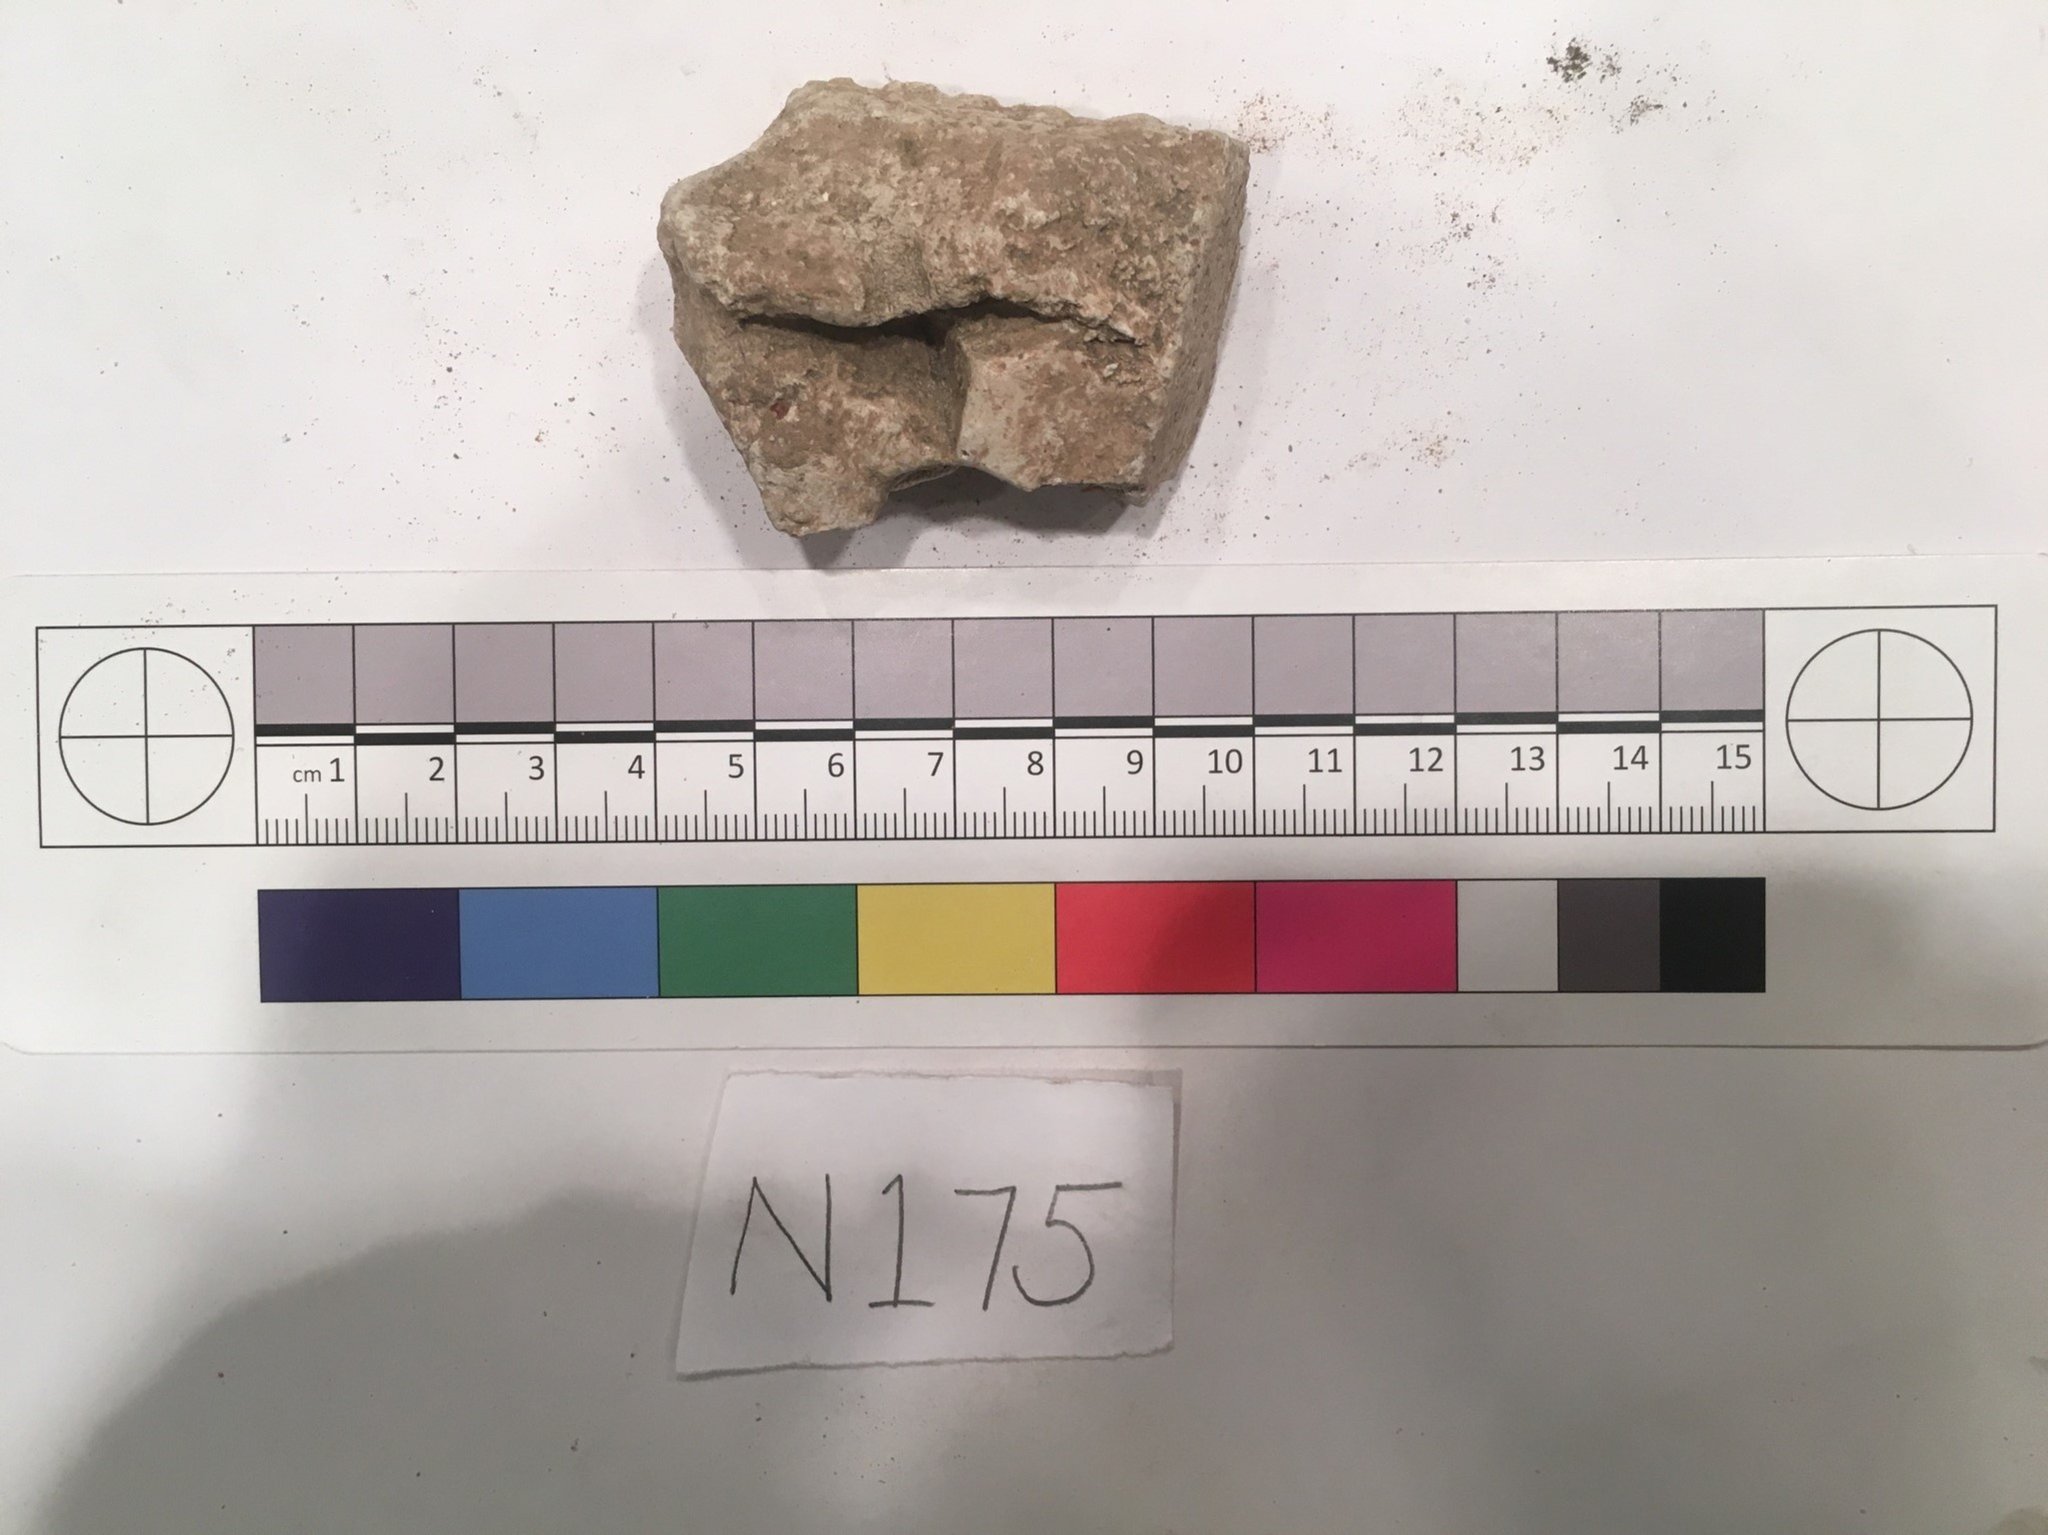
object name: fragment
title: Stucco Fragment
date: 701-1200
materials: plaster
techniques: carving, painting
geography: iran